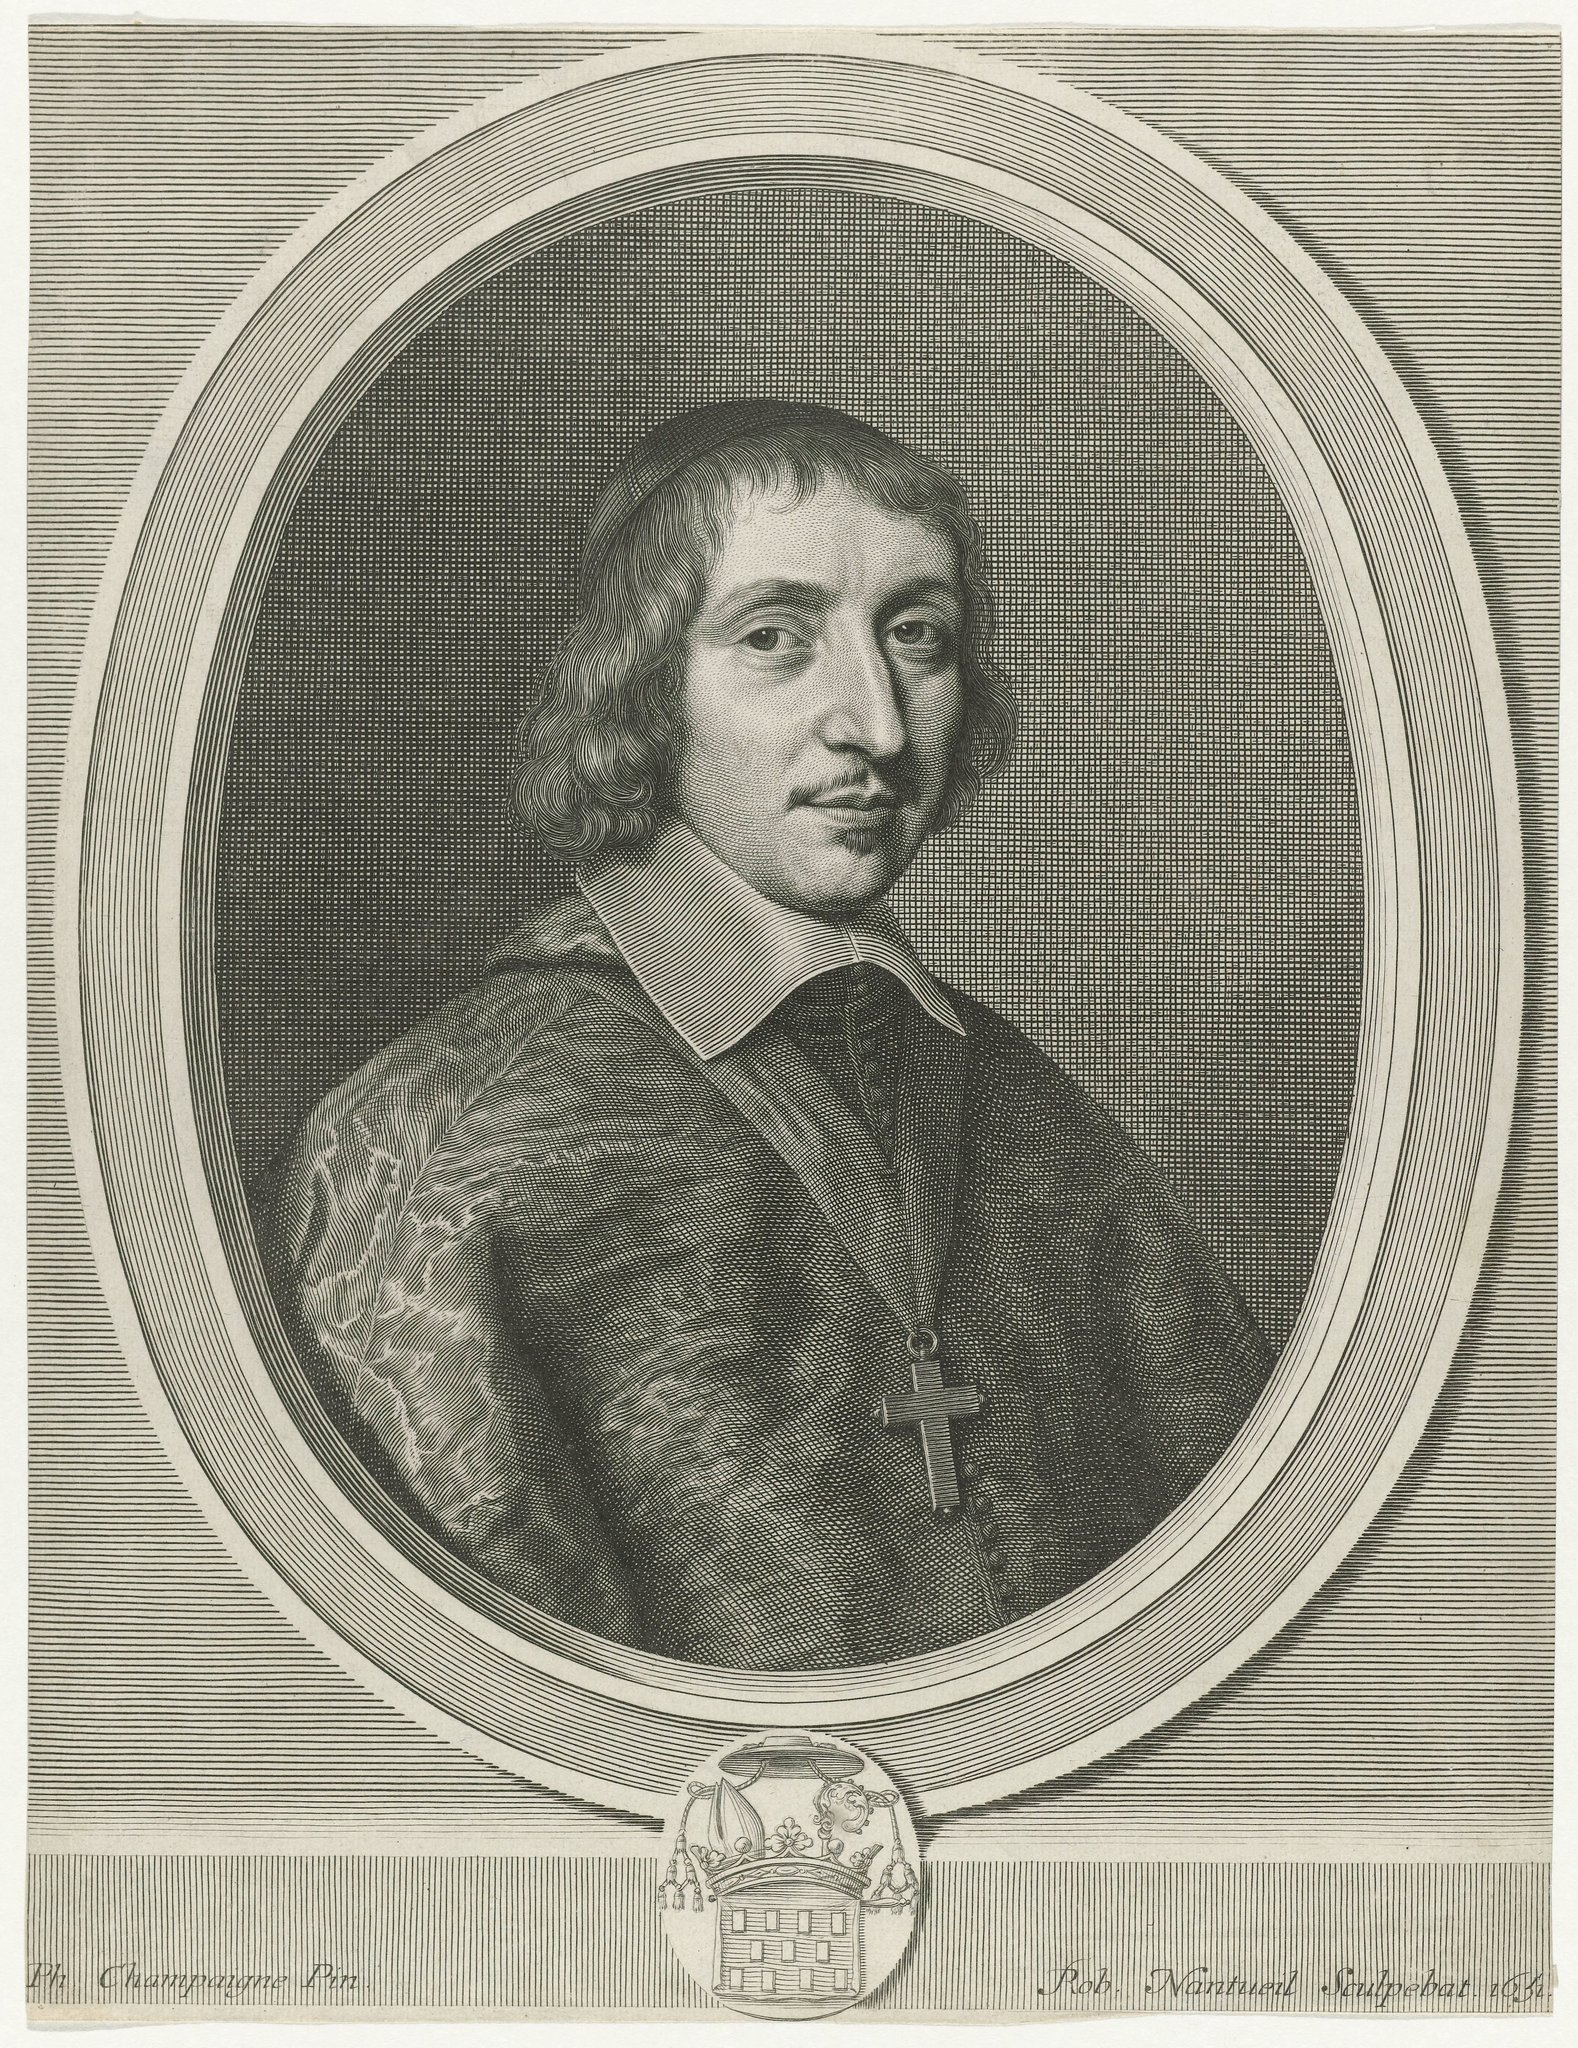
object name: print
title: Portret Philibert Emmanuel de Beaumanoir de Lavardin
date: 1651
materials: paper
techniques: engraving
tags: bisschop, philibert emmanuel de beaumanoir de lavardin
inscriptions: date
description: Buste naar rechts, in ovale lijst. Wapen middenonder.